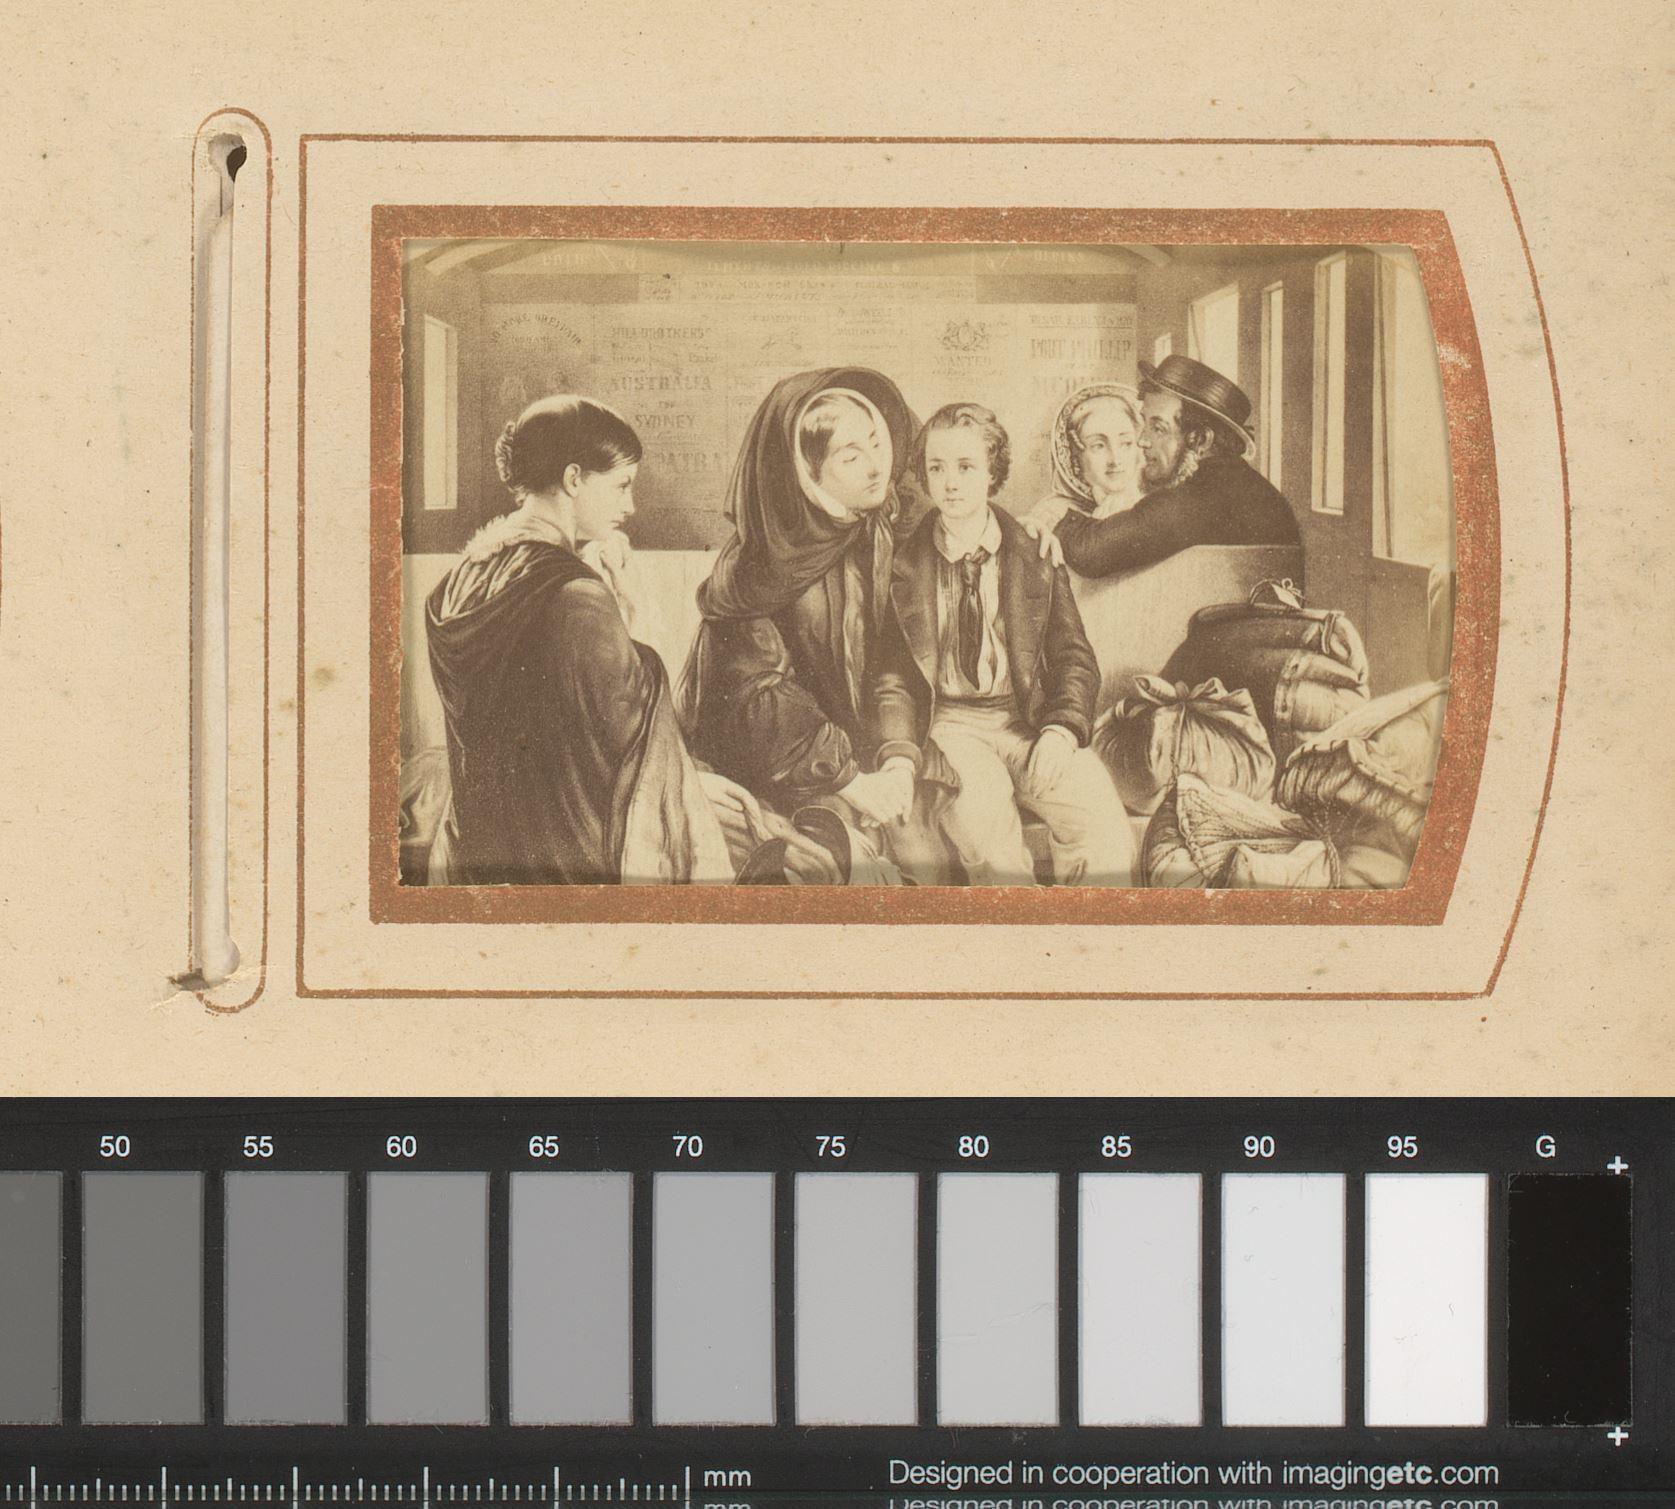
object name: album leaf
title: Fotoreproductie van een schilderij van vijf mensen en hun bagage tijdens een reis door A. Salomon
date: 1850-1900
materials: cardboard, photographic support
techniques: albumen print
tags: boy (child between toddler and youth), adult man, adult woman (+ three persons), departure ~ travelling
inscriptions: inscription: ‘Salomon./ 642./ Le départ./ Die Abreise. (II Classe.)/ The departure.’